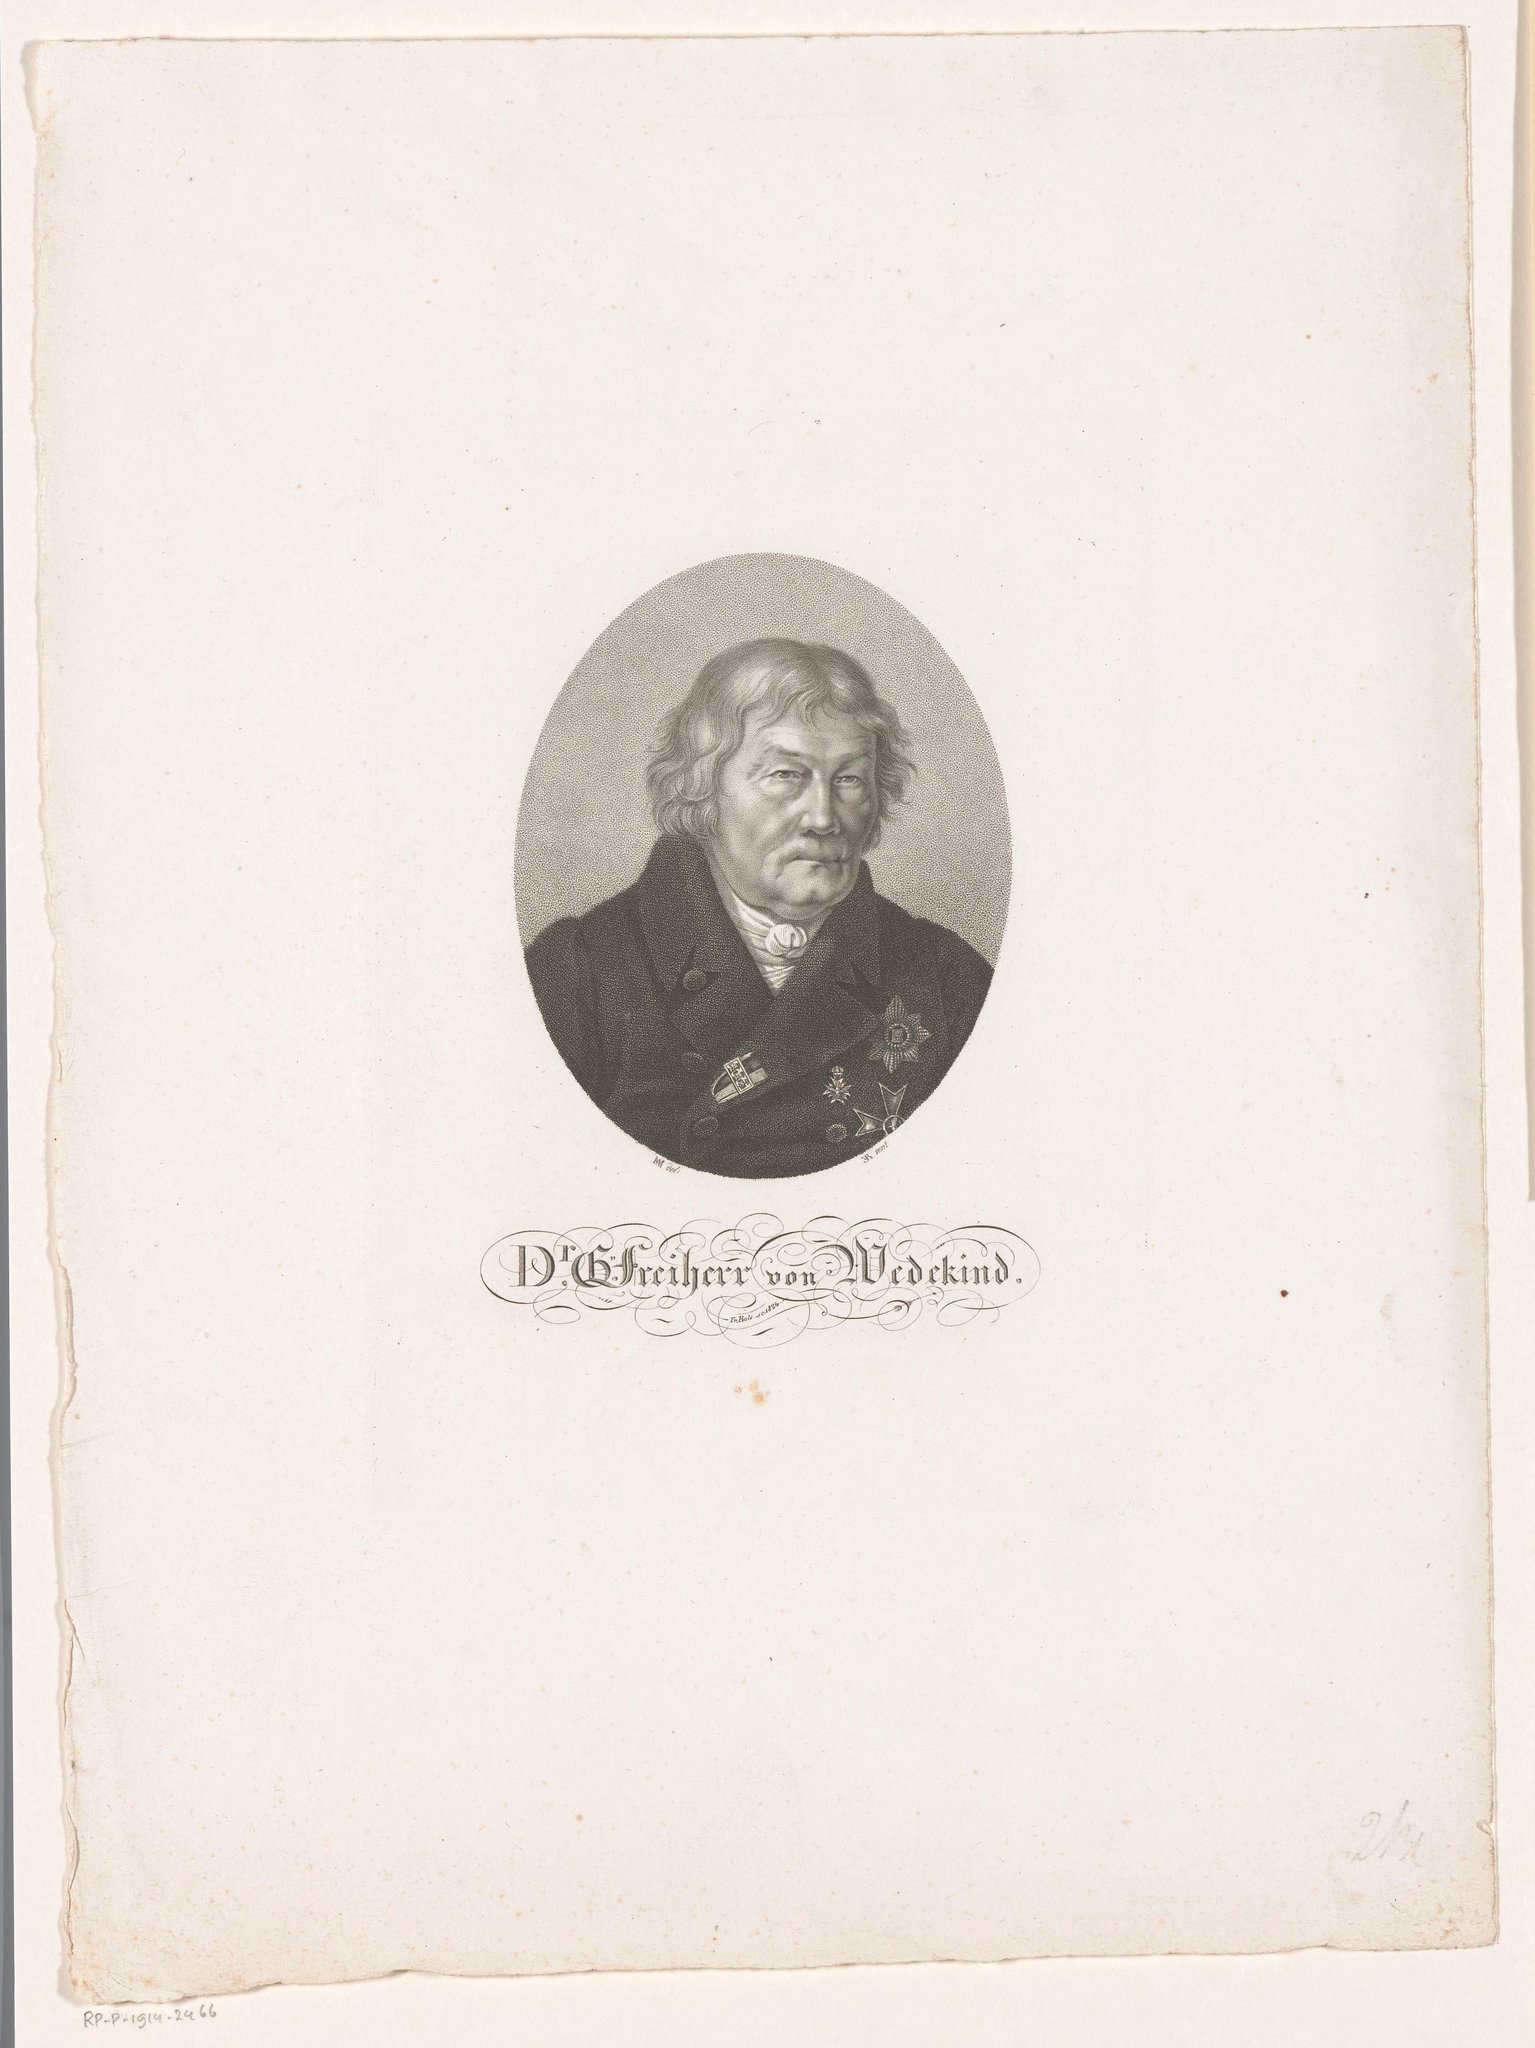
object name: print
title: Portret van Georg Christian Gottlieb, Freiherr von Wedekind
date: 1826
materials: paper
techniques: stippling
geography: berlin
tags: knighthood order, historical persons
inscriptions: collector's mark: Lugt 2228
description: Mogelijk is de prent van Johann Friedrich Bolt opgewerkt en voorzien van eretekens door monogrammist ER.